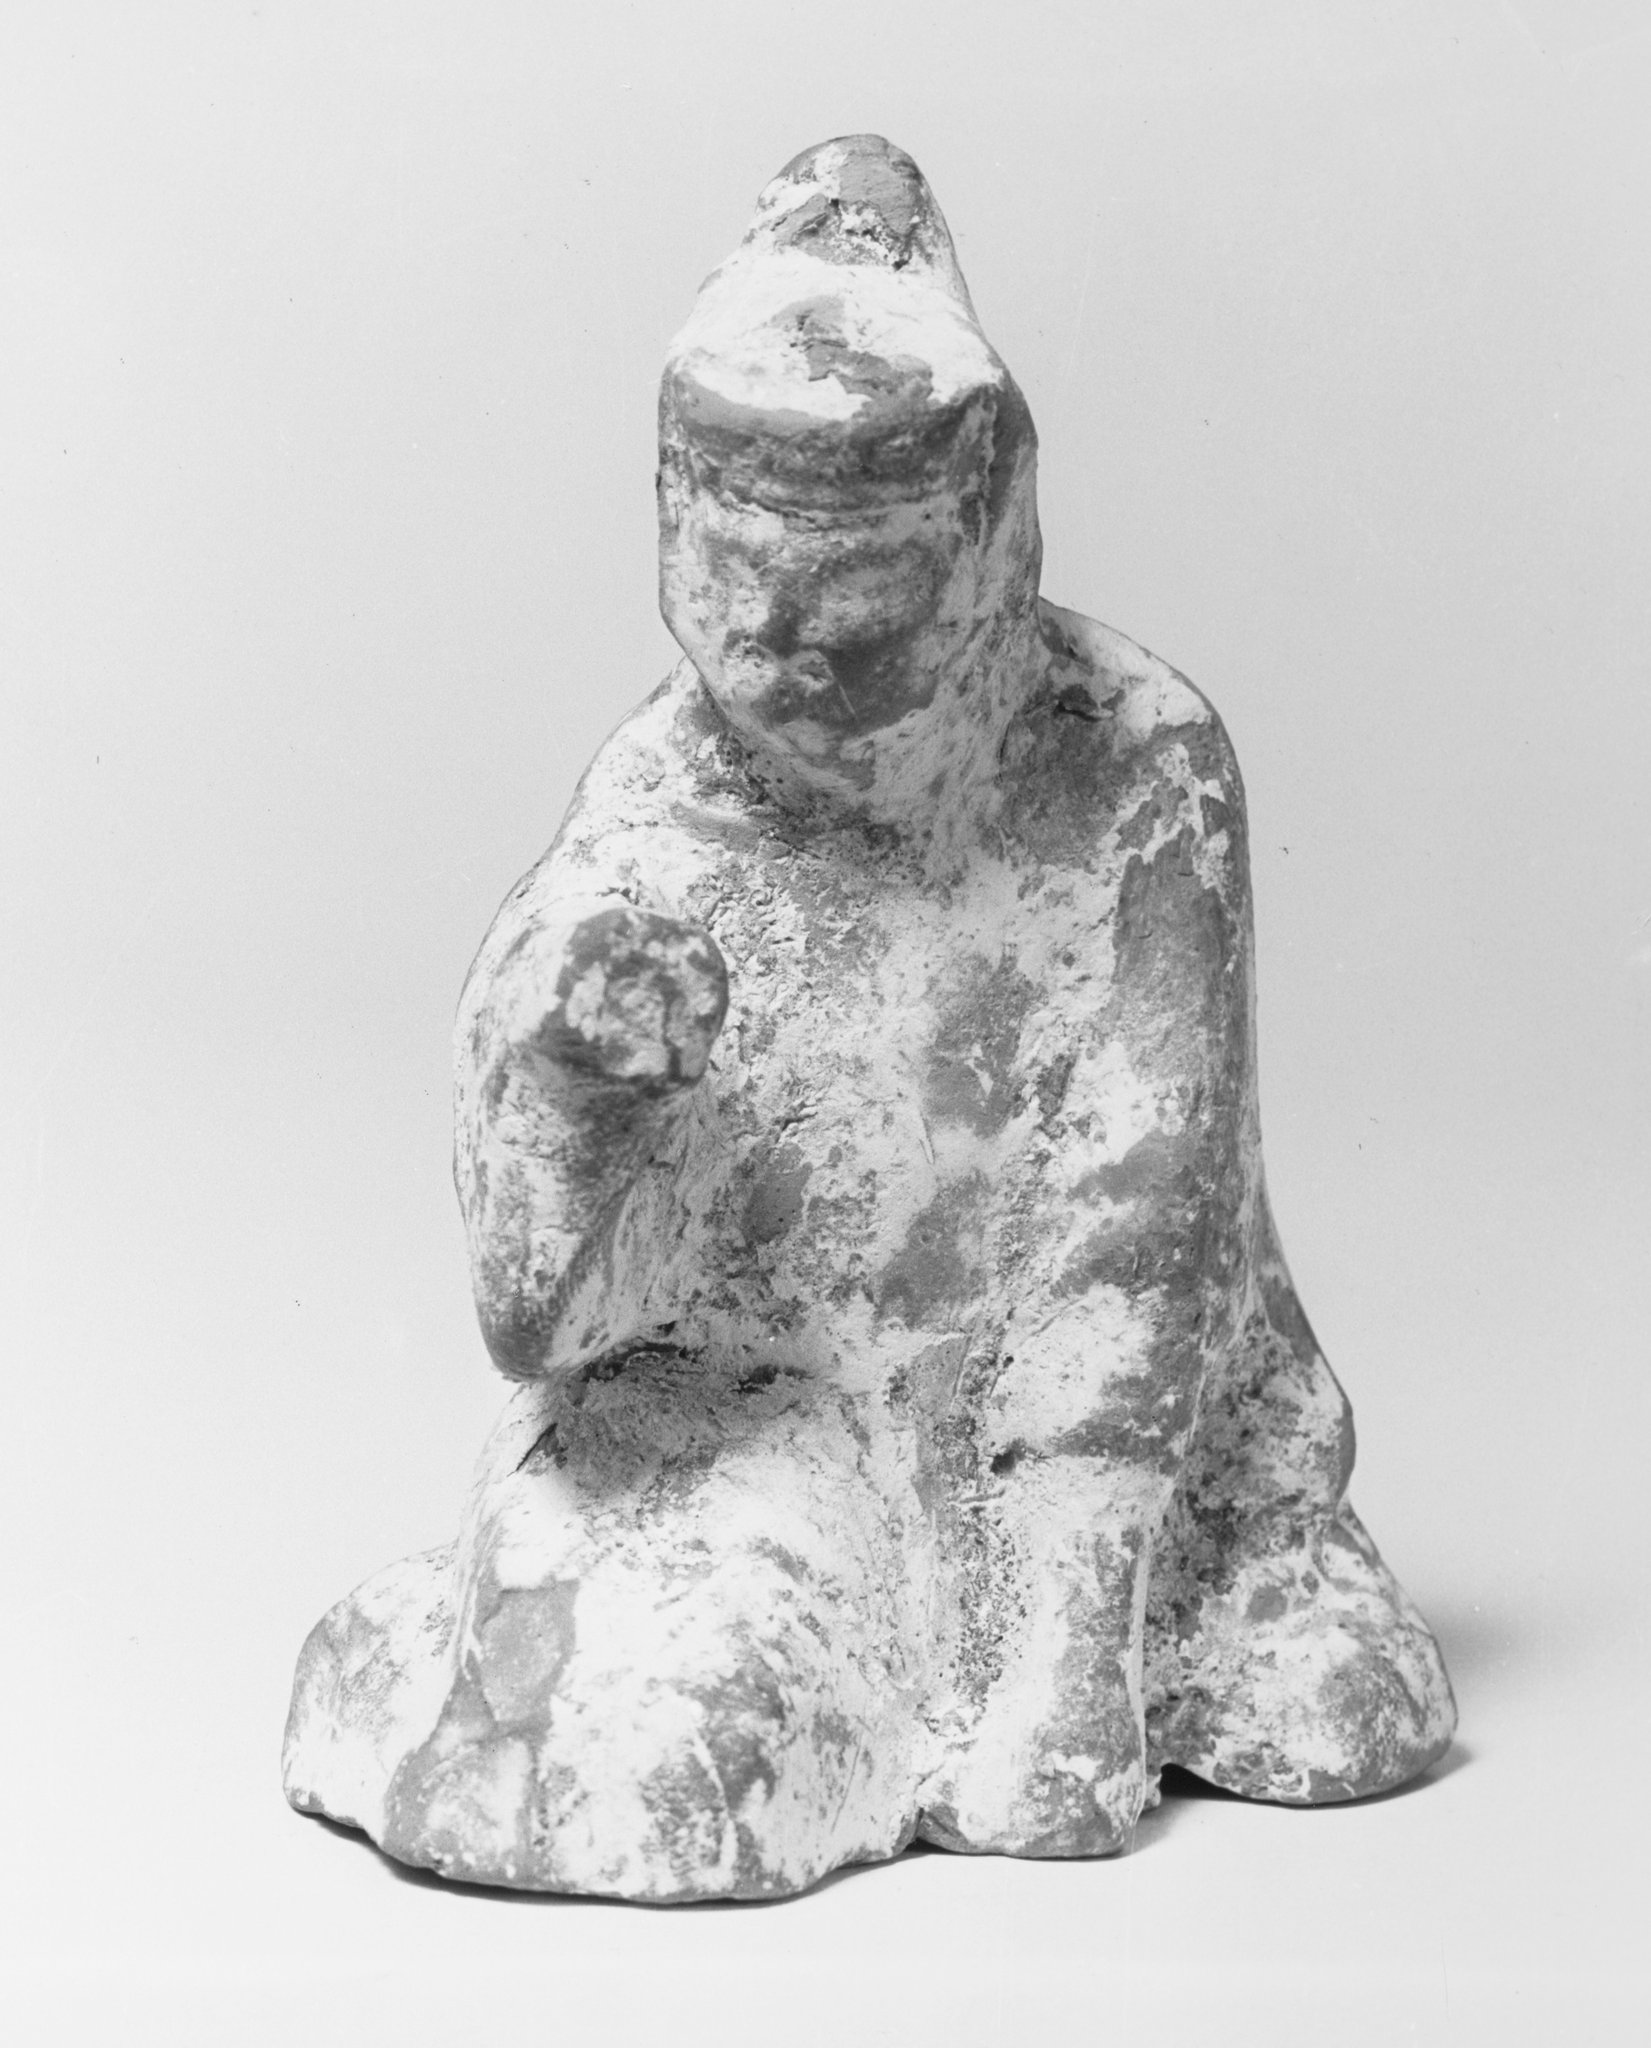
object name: figure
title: Kneeling Figure of Musician or Dancer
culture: chinese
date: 206 BCE-220 CE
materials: paint, pottery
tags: human figures,musicians